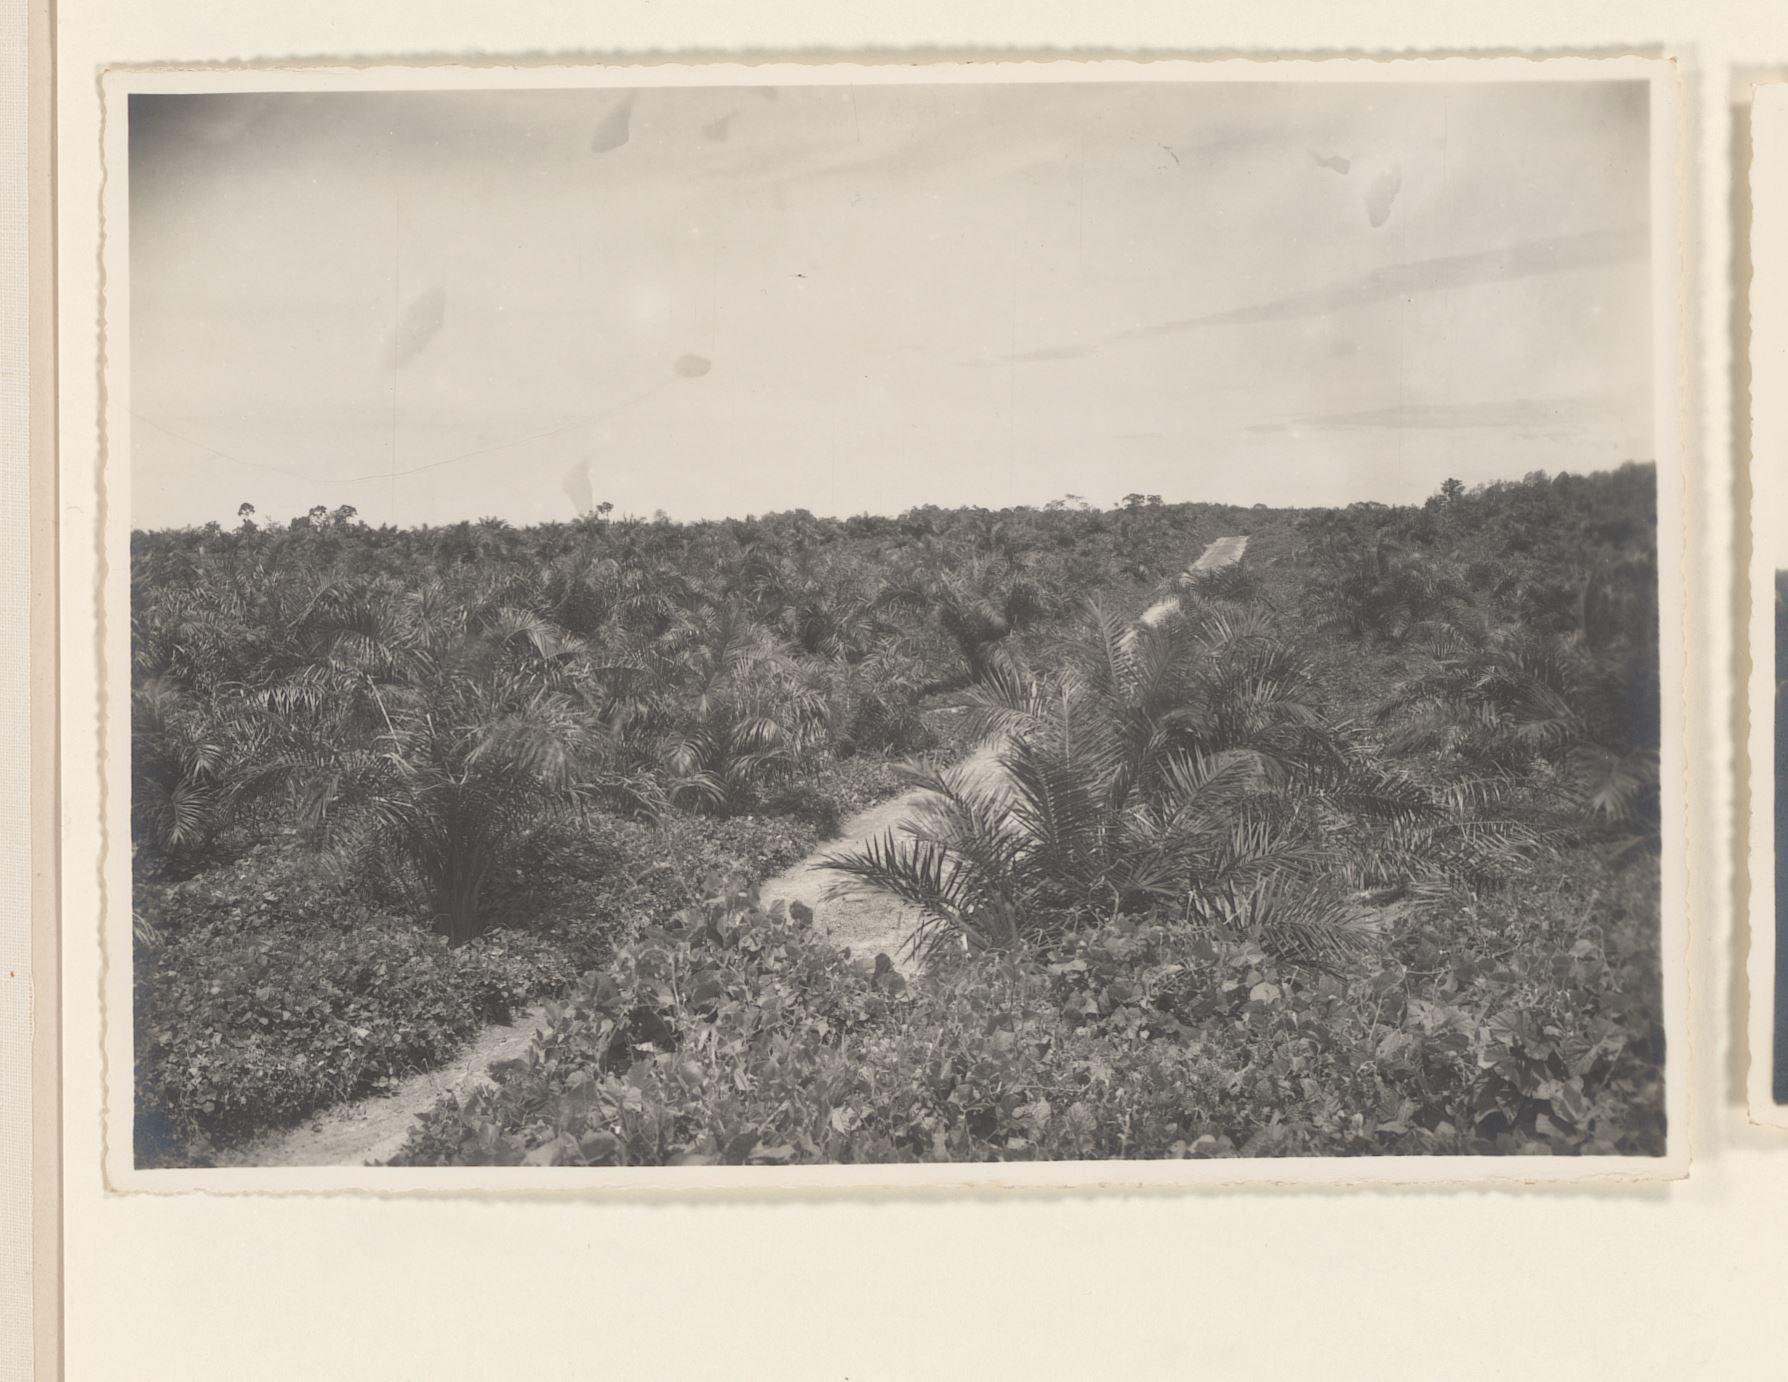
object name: photograph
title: Oliepalmenaanplant op Brussel, 1938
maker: Anonymous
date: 1906-1938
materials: photographic support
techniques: gelatin silver print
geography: sumatra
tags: plantation, (non-fruit) products of plants or trees: palm oil, sumatra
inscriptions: inscription: ‘Oliepalmen afd. IV Brussel’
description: Oliepalmenaanplant op Brussel, juni 1938. Tweede afdruk, los in melinexhoesje, van een foto ingeplakt op albumblad 9. Onderdeel van het fotoalbum over de plantages Pernantian en Brussel van de Sumatra Caoutchouc Maatschappij op de Oostkust van Sumatra in de jaren 1935-1939.